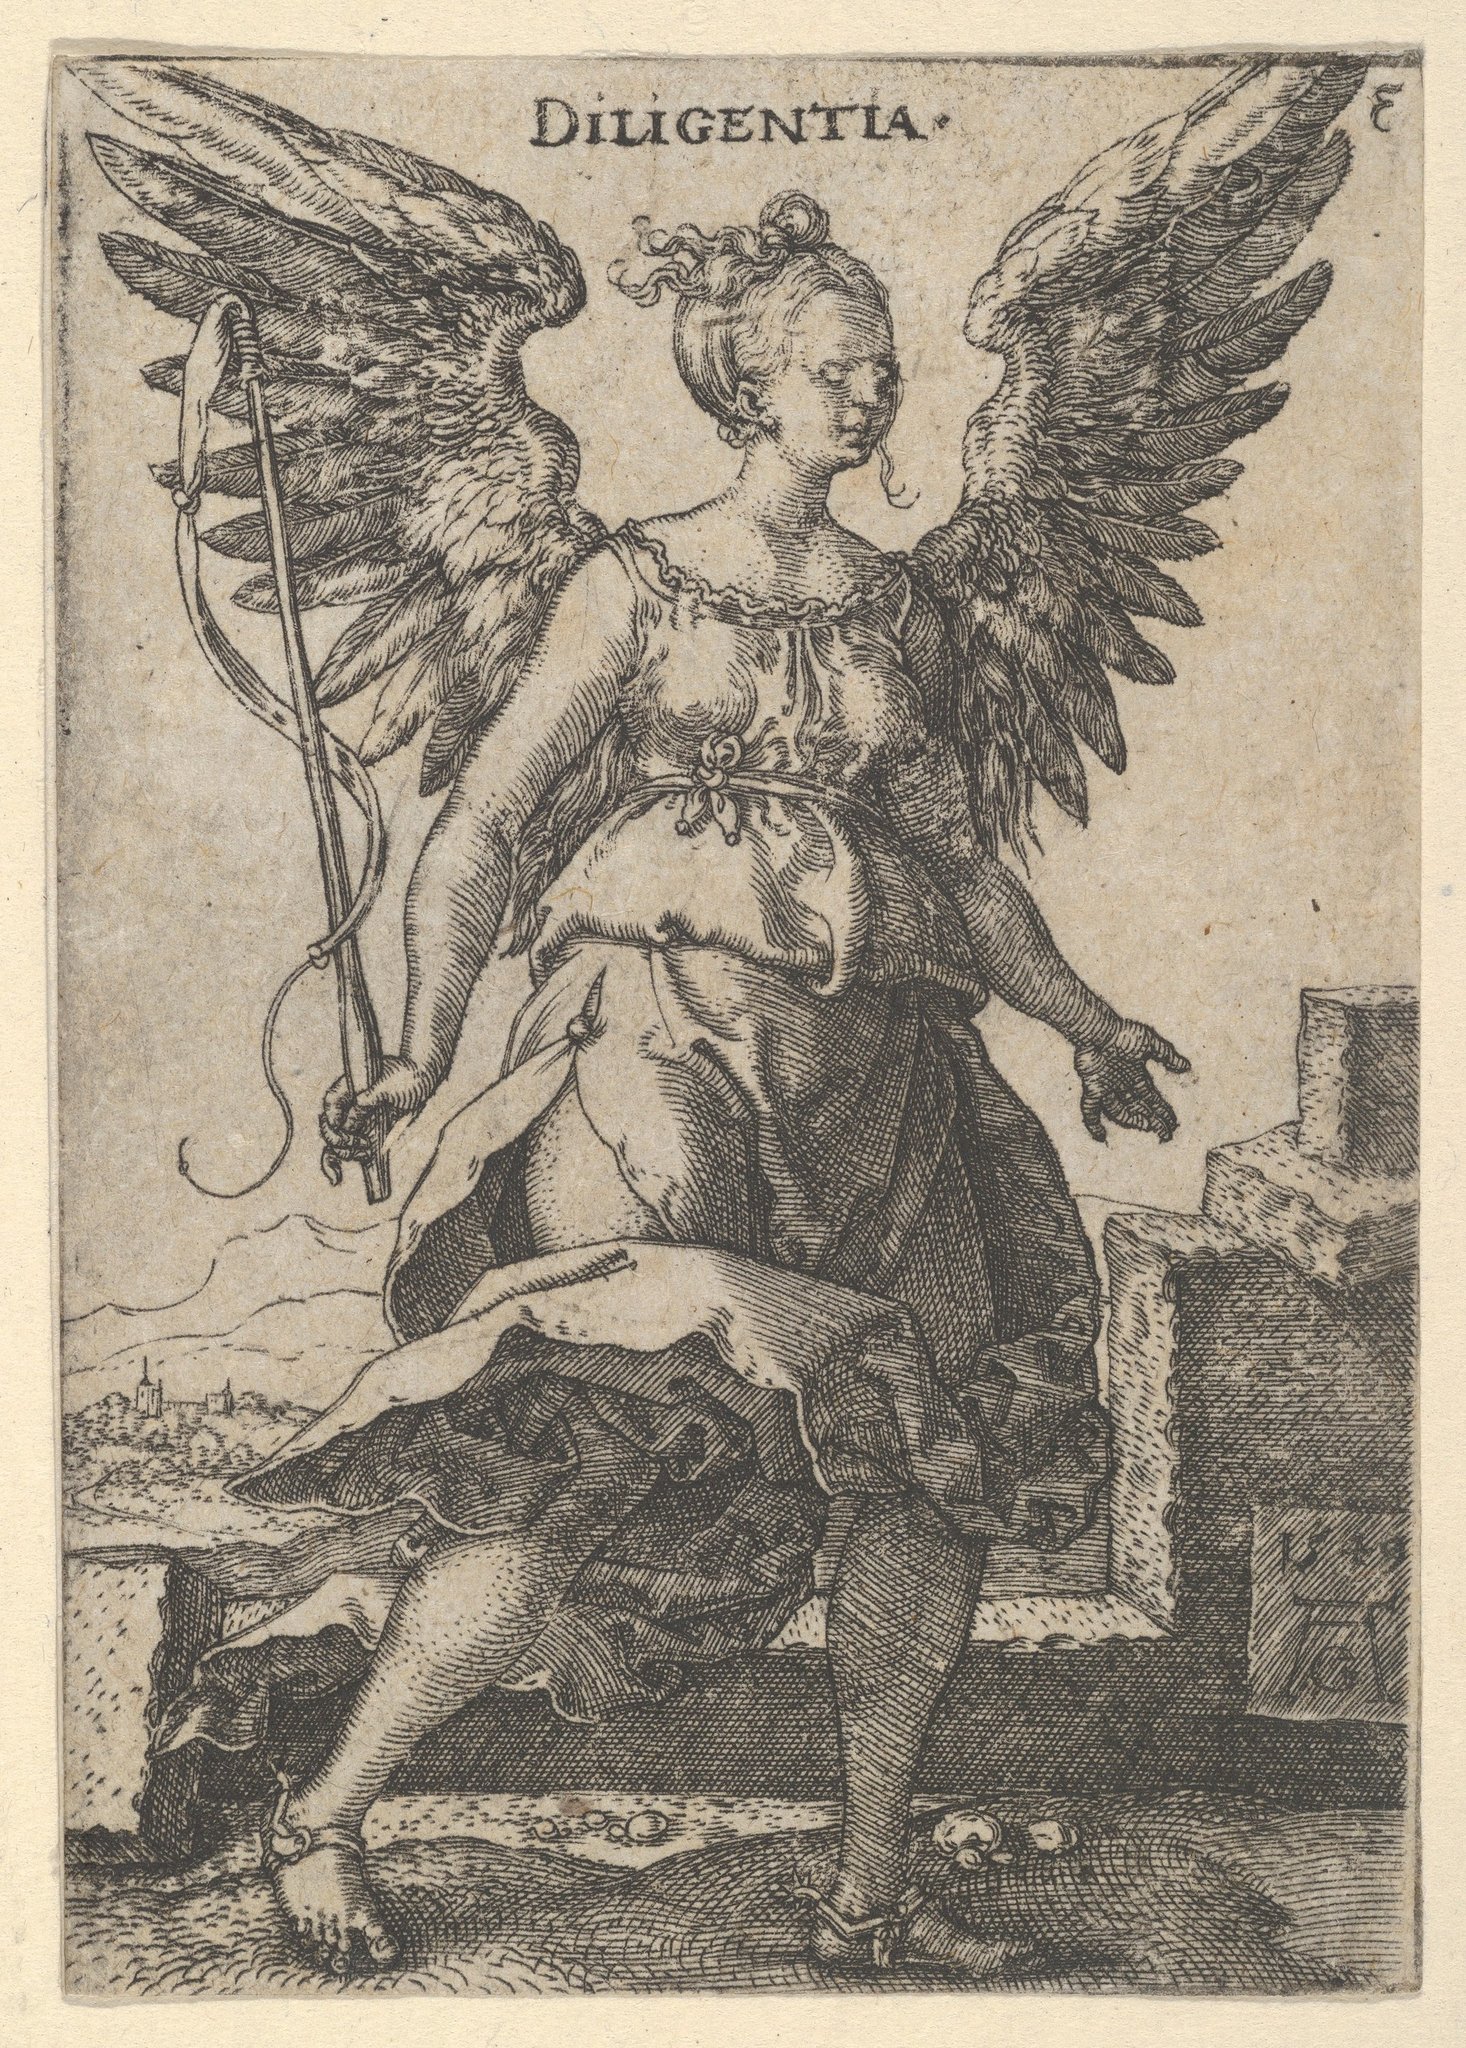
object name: print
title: Diligence, from "Virtues and Vices"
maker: heinrich aldegrever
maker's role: artist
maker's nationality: german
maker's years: 1502-1561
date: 1549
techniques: engraving